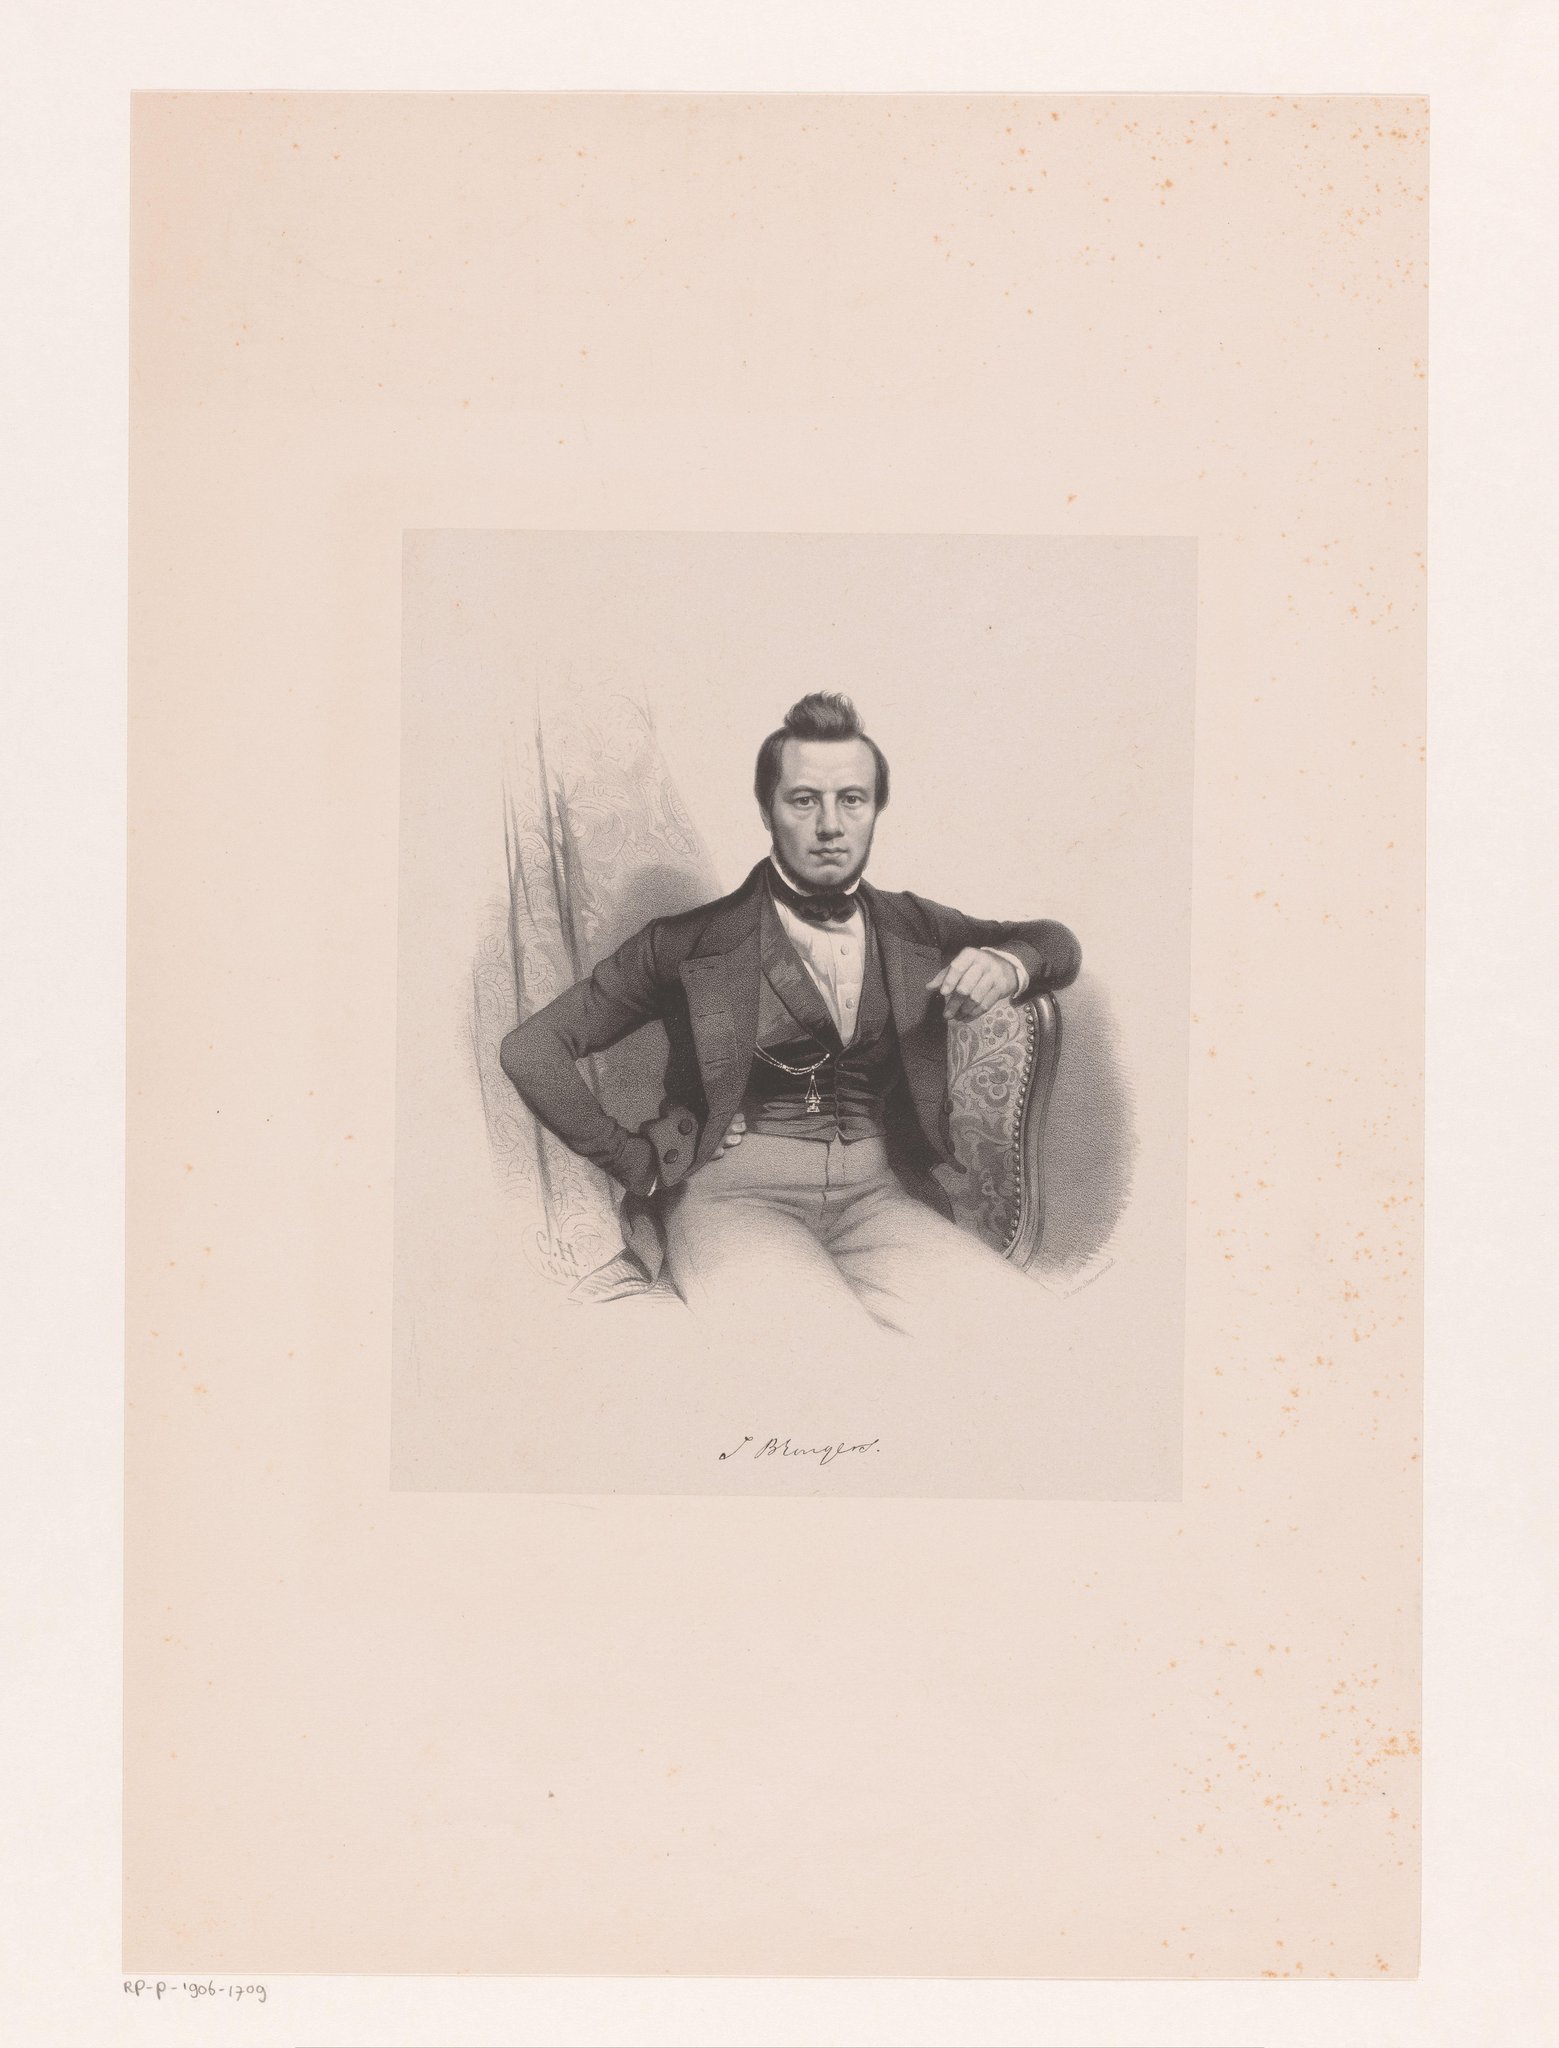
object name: print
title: Portret van J. Brongers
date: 1844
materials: paper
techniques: lithograph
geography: the hague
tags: historical persons (+ half-length portrait)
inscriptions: collector's mark: Lugt 2228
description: De geportretteerde draagt een horlogeketting met daaraan een hanger. Onder het portret zijn signatuur.